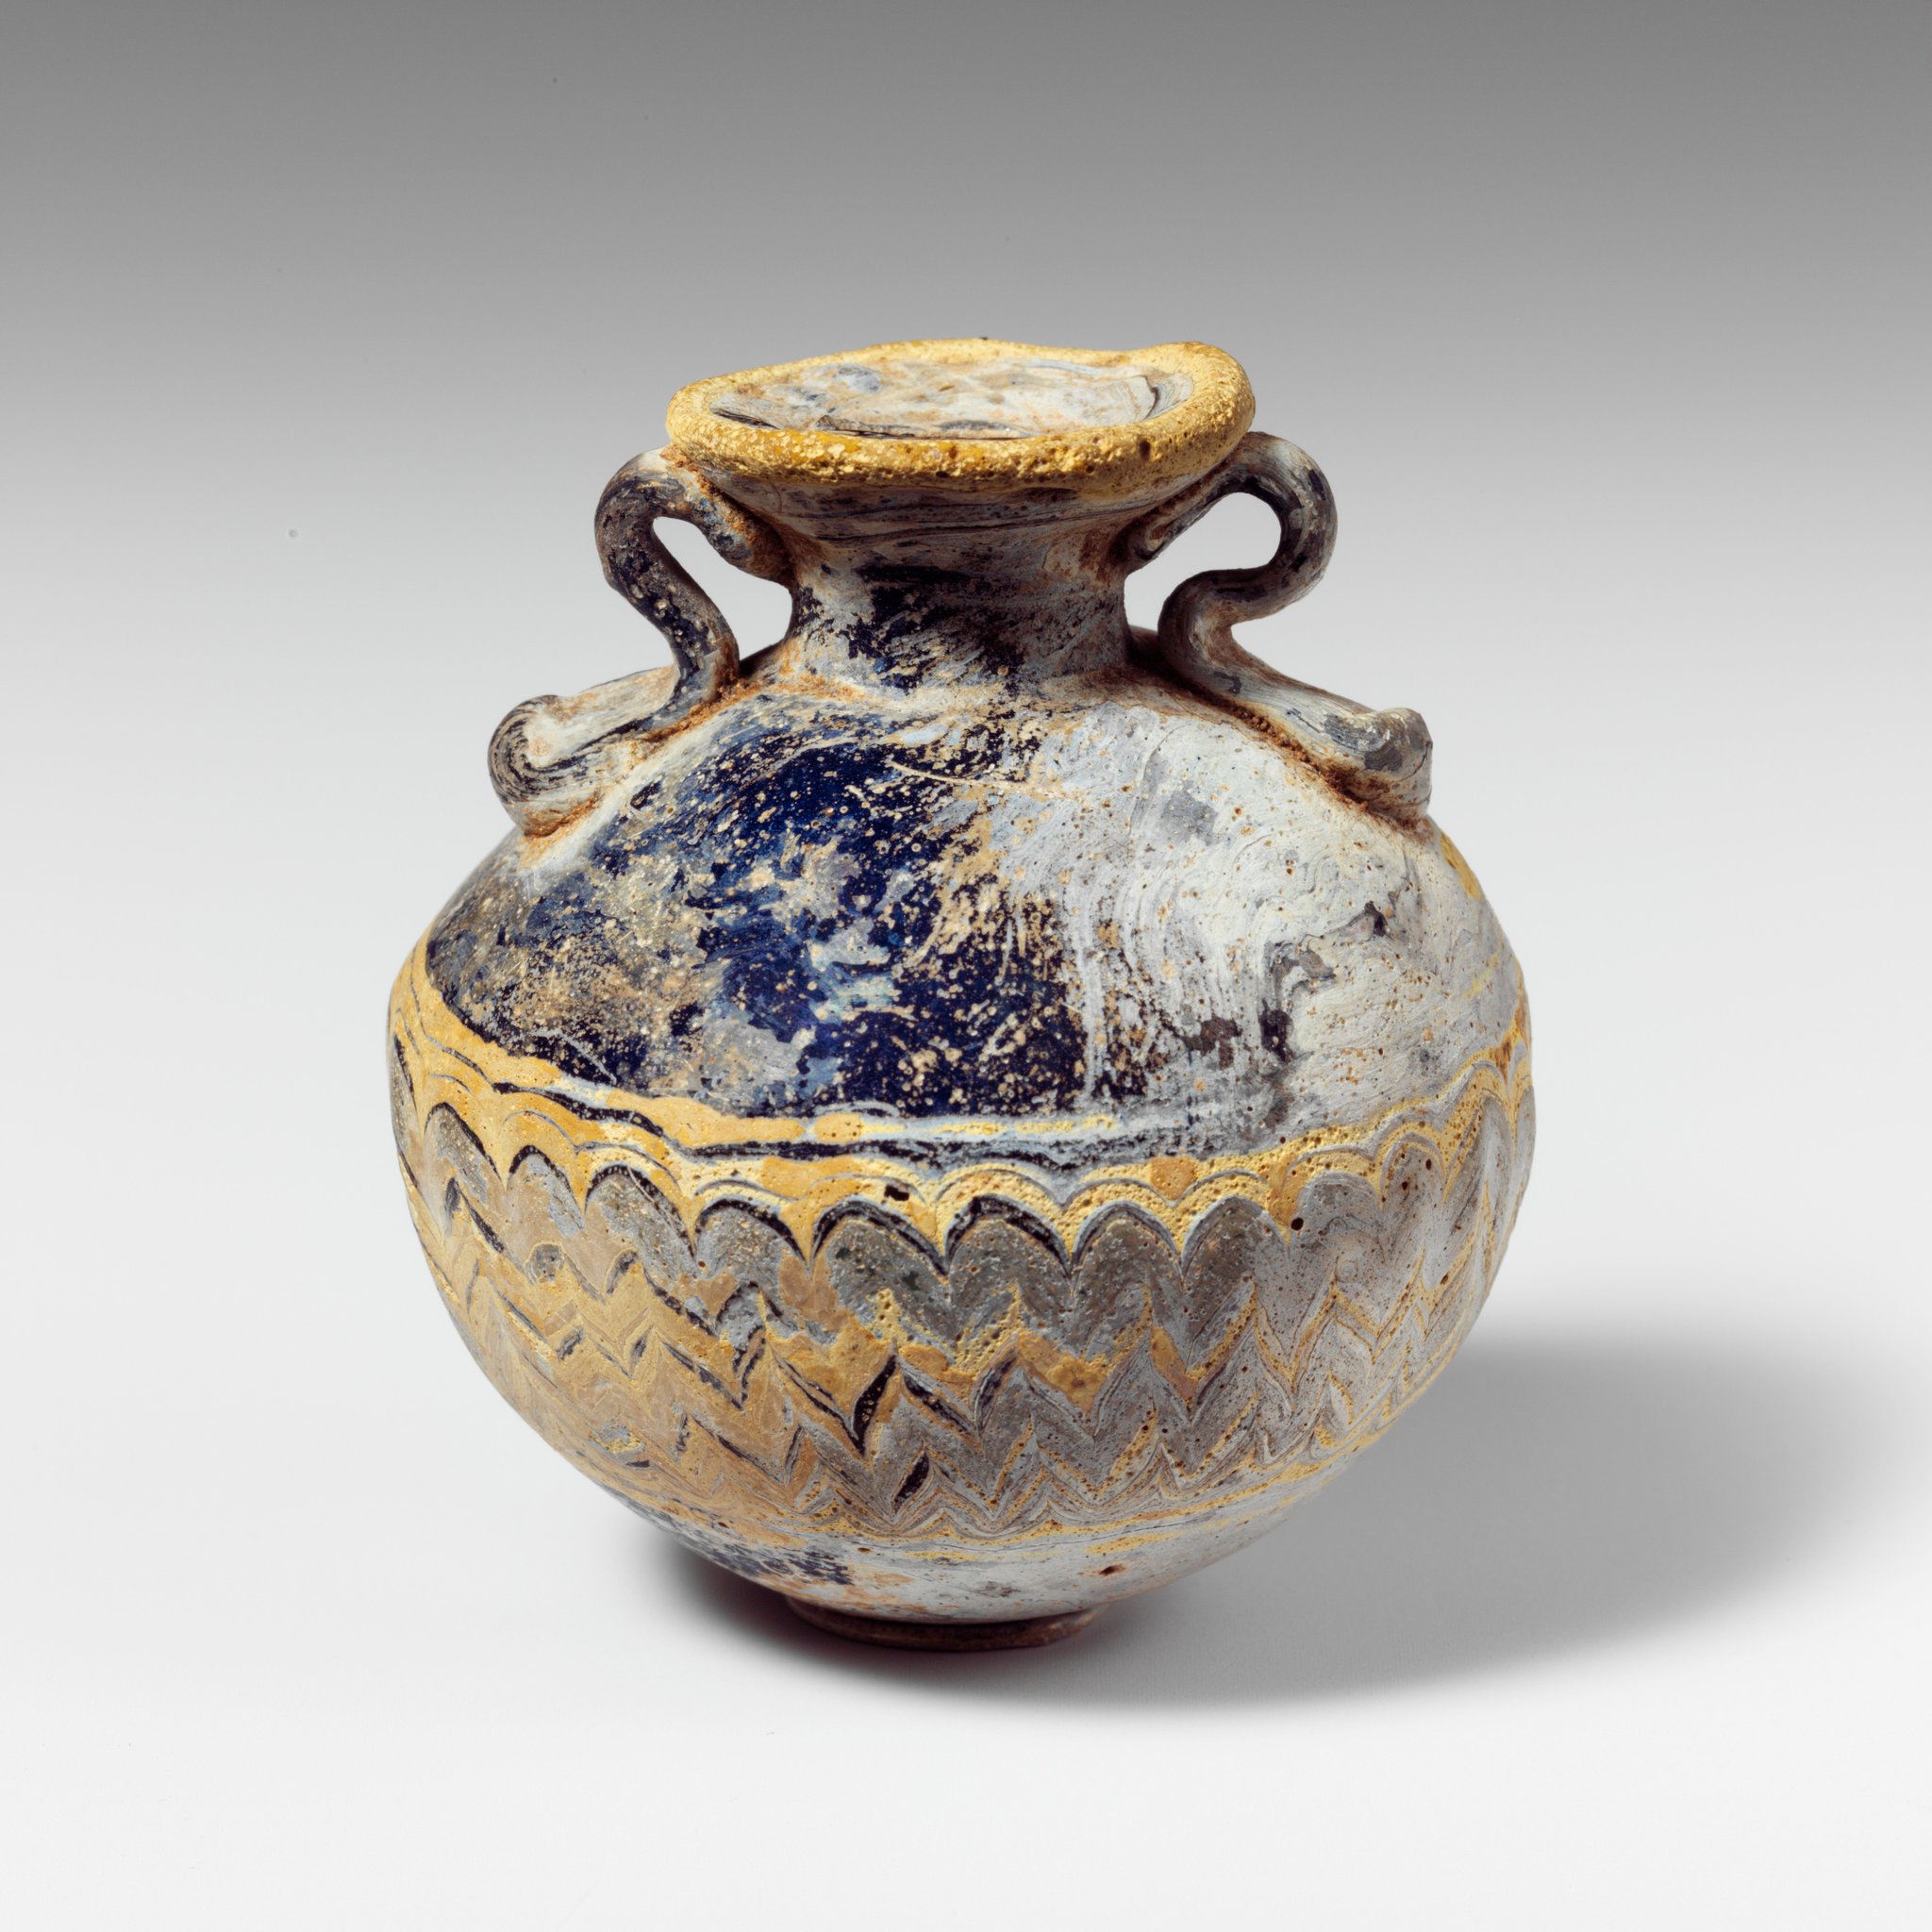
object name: aryballos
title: Glass aryballos (perfume bottle)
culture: greek, eastern mediterranean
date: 534-401 BCE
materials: glass